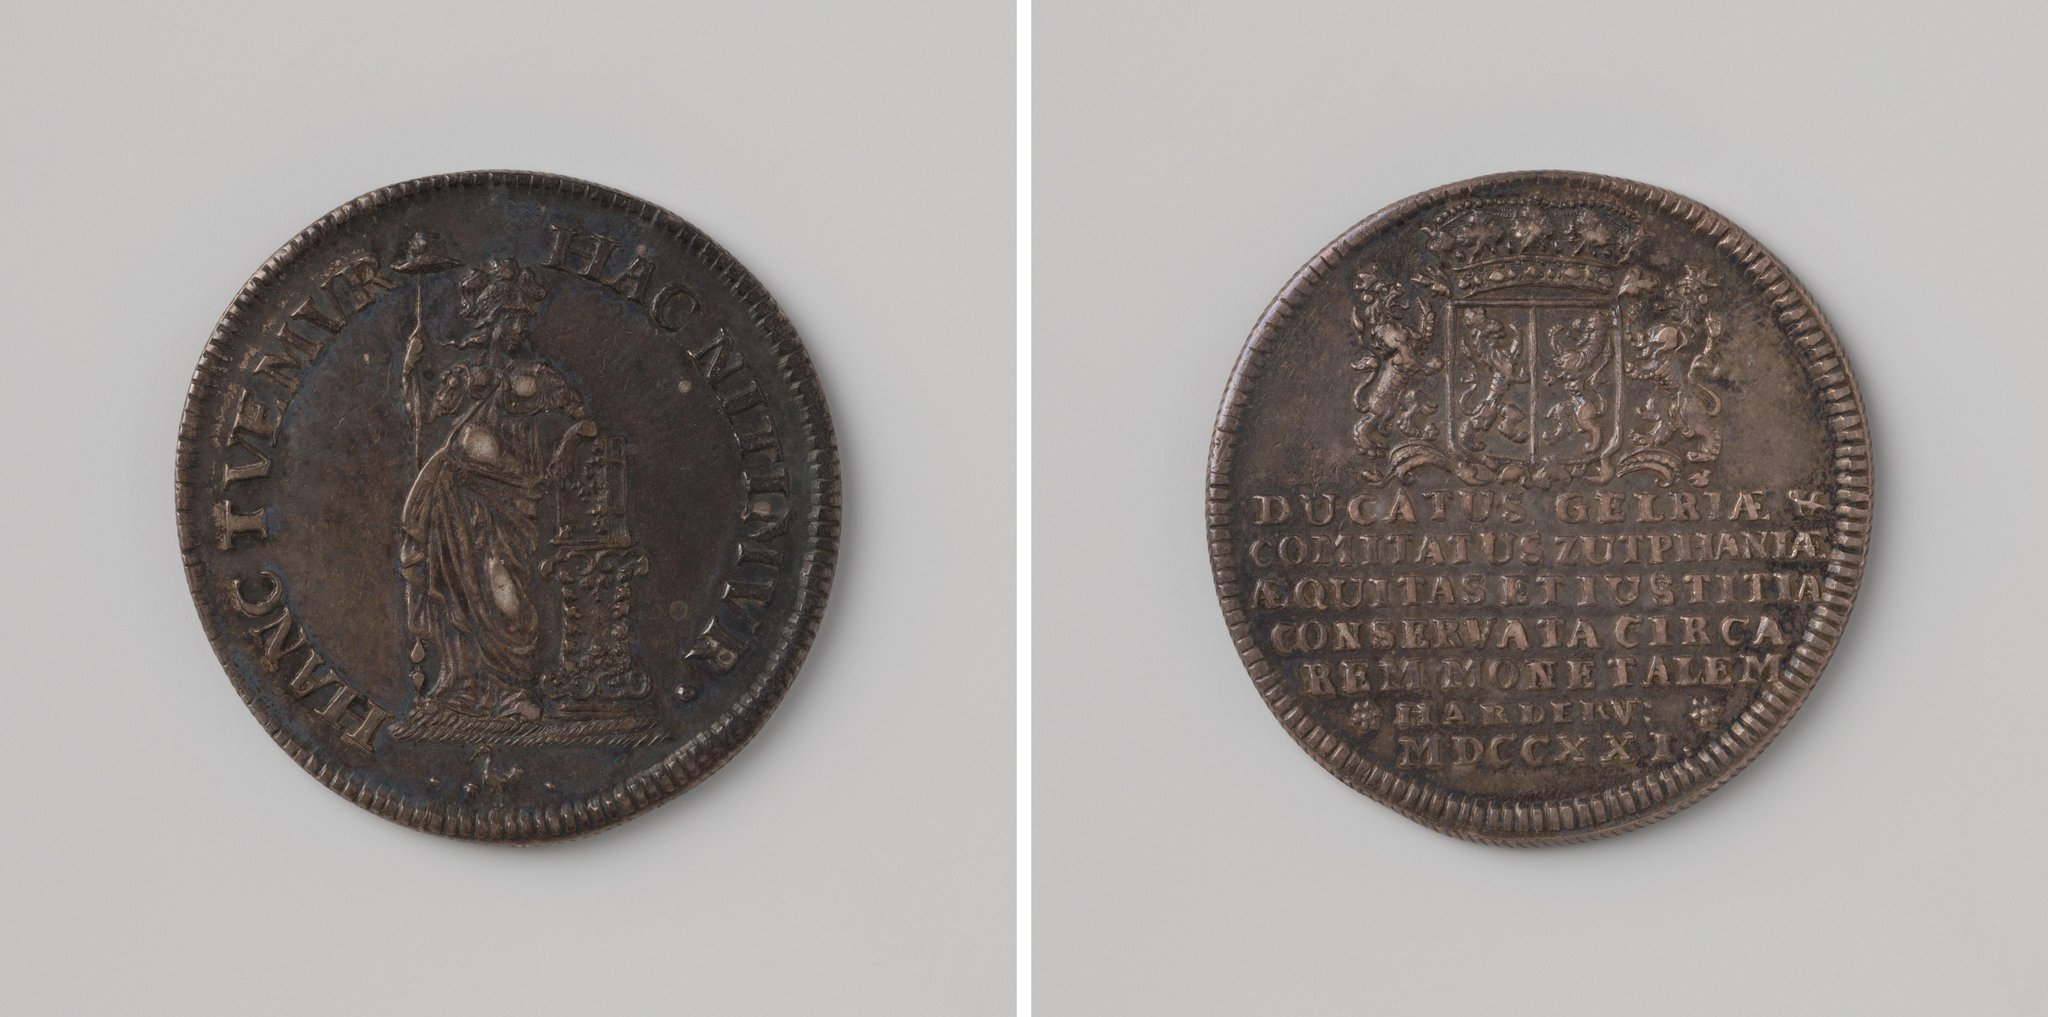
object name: history medal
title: Handhaving van de munt te Harderwijk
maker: Anonymous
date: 1721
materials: silver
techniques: striking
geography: harderwijk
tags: staten van gelderland, staten van zutphen, harderwijk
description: Zilveren penning. Voorzijde: Nederlandse maagd met vrijheidshoed op speer leunt met arm op bijbel staand op altaar binnen omschrift (stempel van twee guldenstuk); onder afbeelding: vogel tussen twee sterren (merkteken van munt van Harderwijk). Keerzijde: opschrift onder gekroond wapenschild van Gelderland, geflankeerd door twee gekroonde leeuwen.